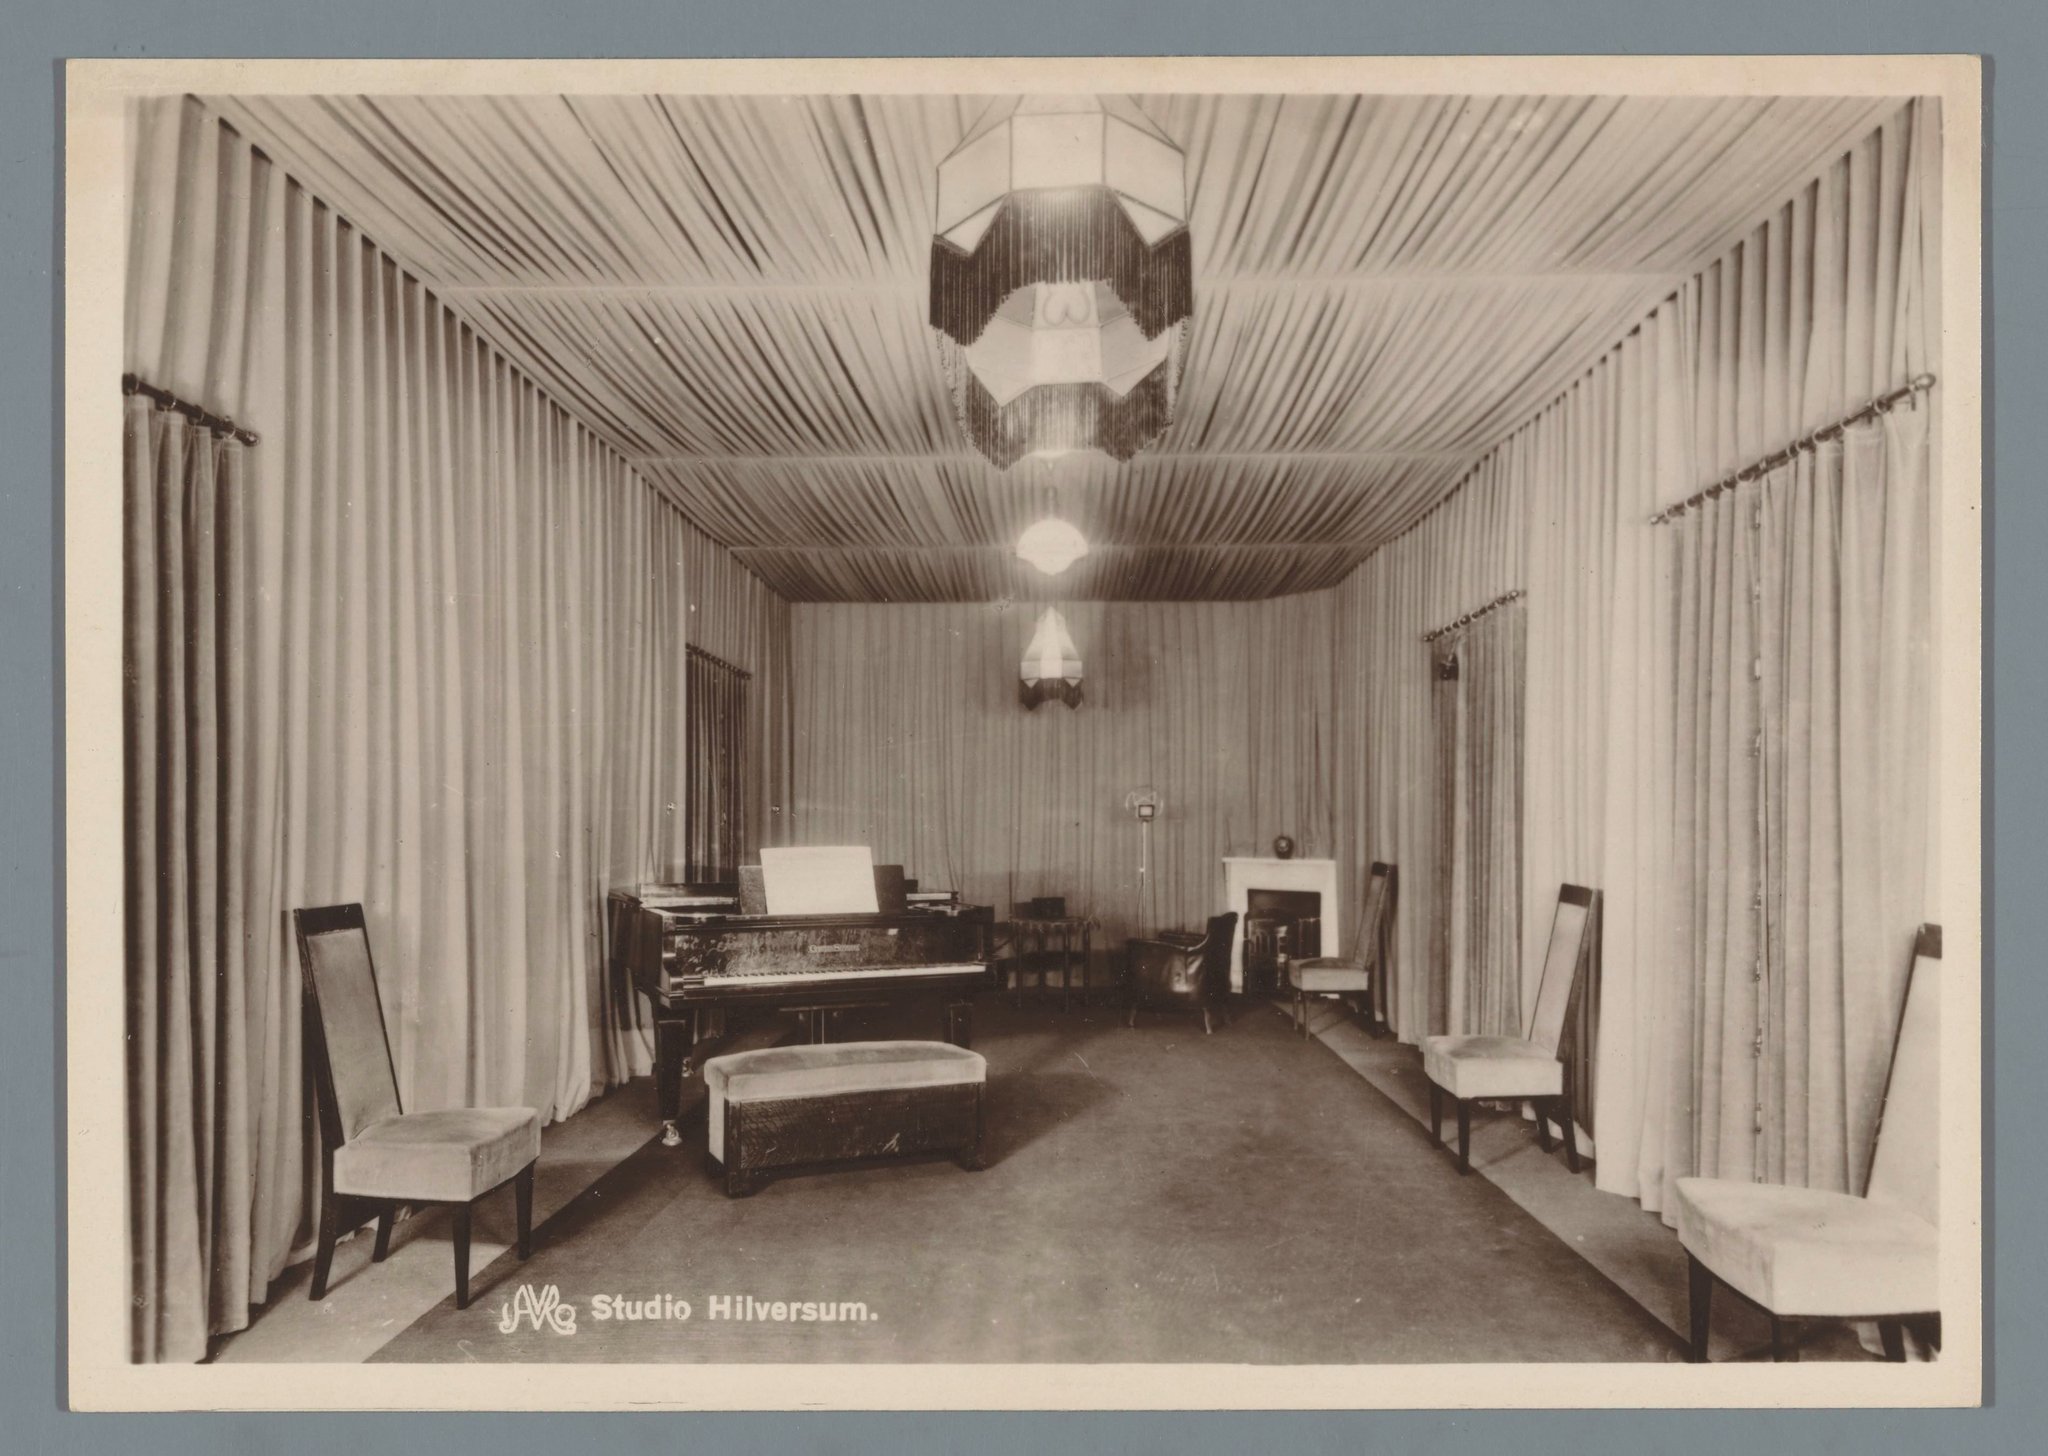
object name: photograph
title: A.V.R.O.-Studio, Hilversum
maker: Anonymous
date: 1928-1945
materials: paper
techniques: gelatin silver print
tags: radio broadcasting studio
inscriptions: number: ‘3’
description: Deze foto maakt deel uit van een omslag met tien foto's.